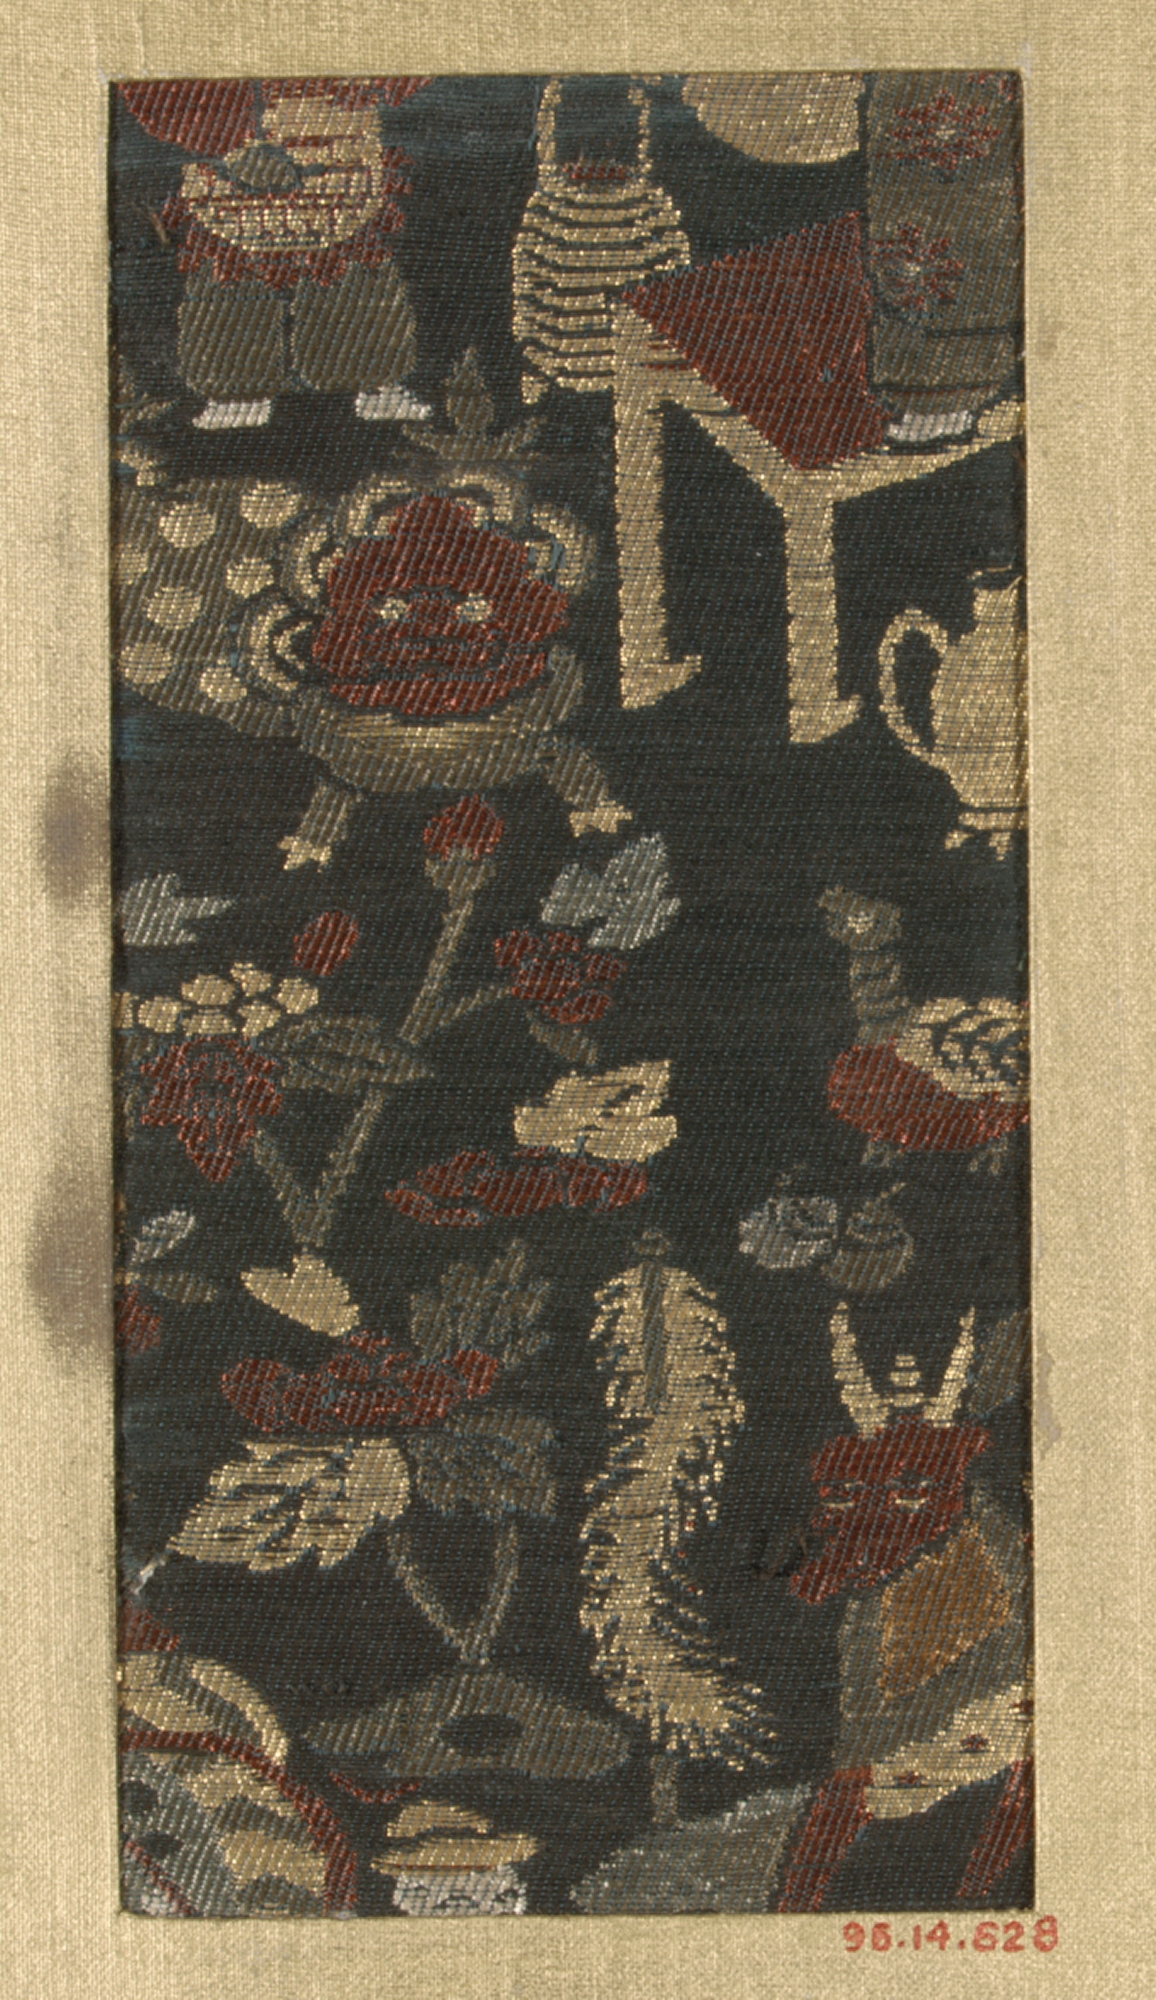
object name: piece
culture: japanese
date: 1701-1900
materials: silk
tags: flowers